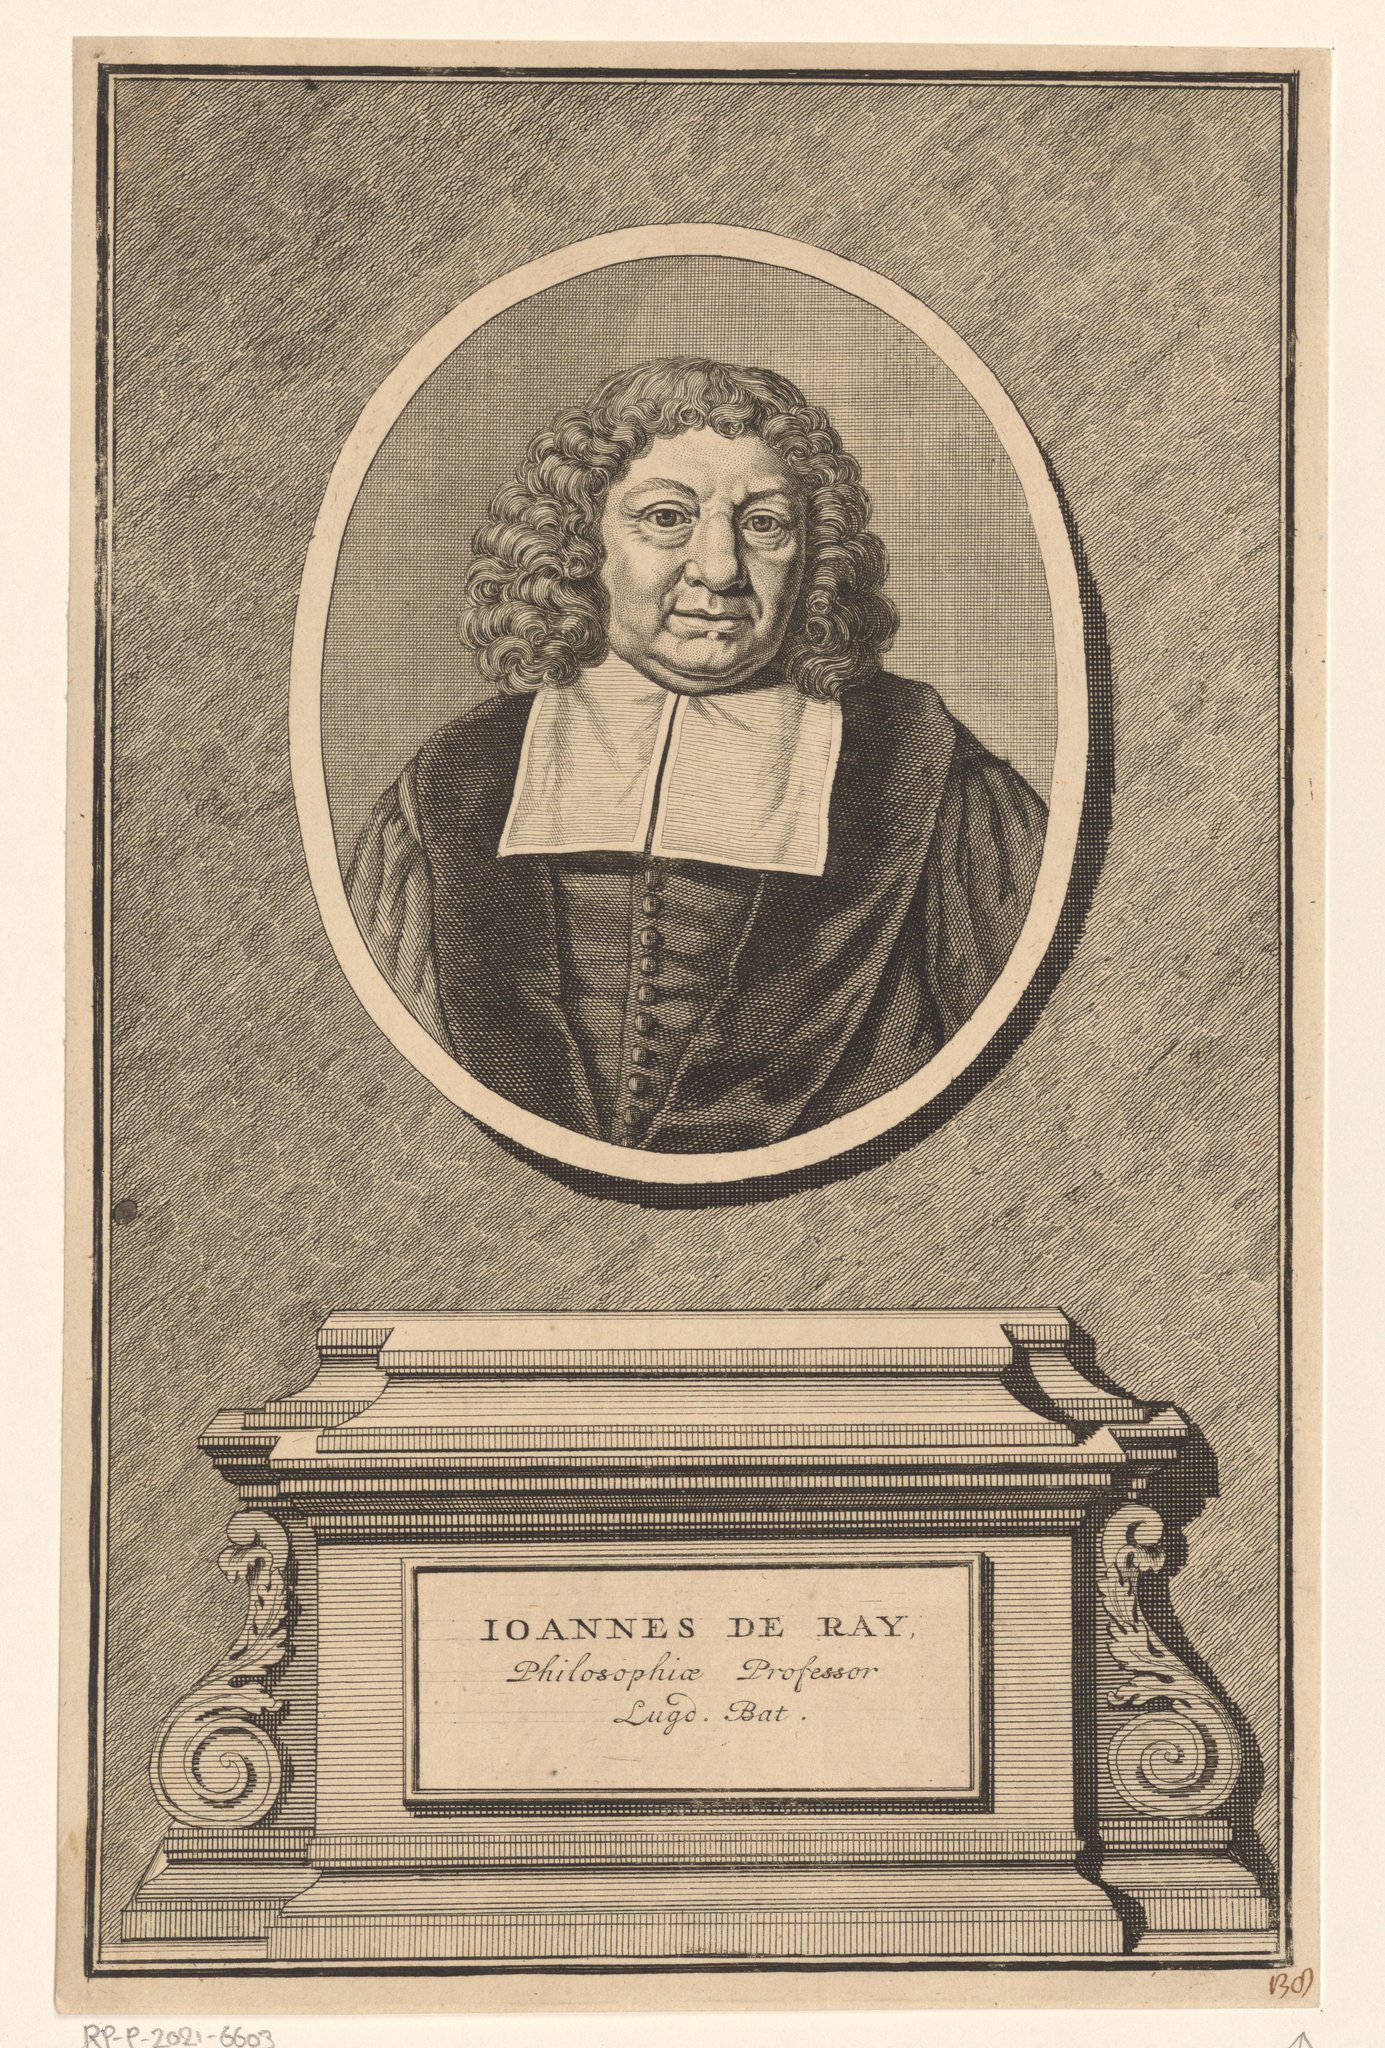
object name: print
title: Portret van Joannes de Ray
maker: Anonymous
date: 1720-1723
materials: paper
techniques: engraving, etching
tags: historical persons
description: Prent mogelijk uit: Fundatoris, Curatorum et Professorum celeberrimorum aliorumque illustrium virorum, quorum gratia (...). Leiden: Pieter van der Aa, [1720-1723].